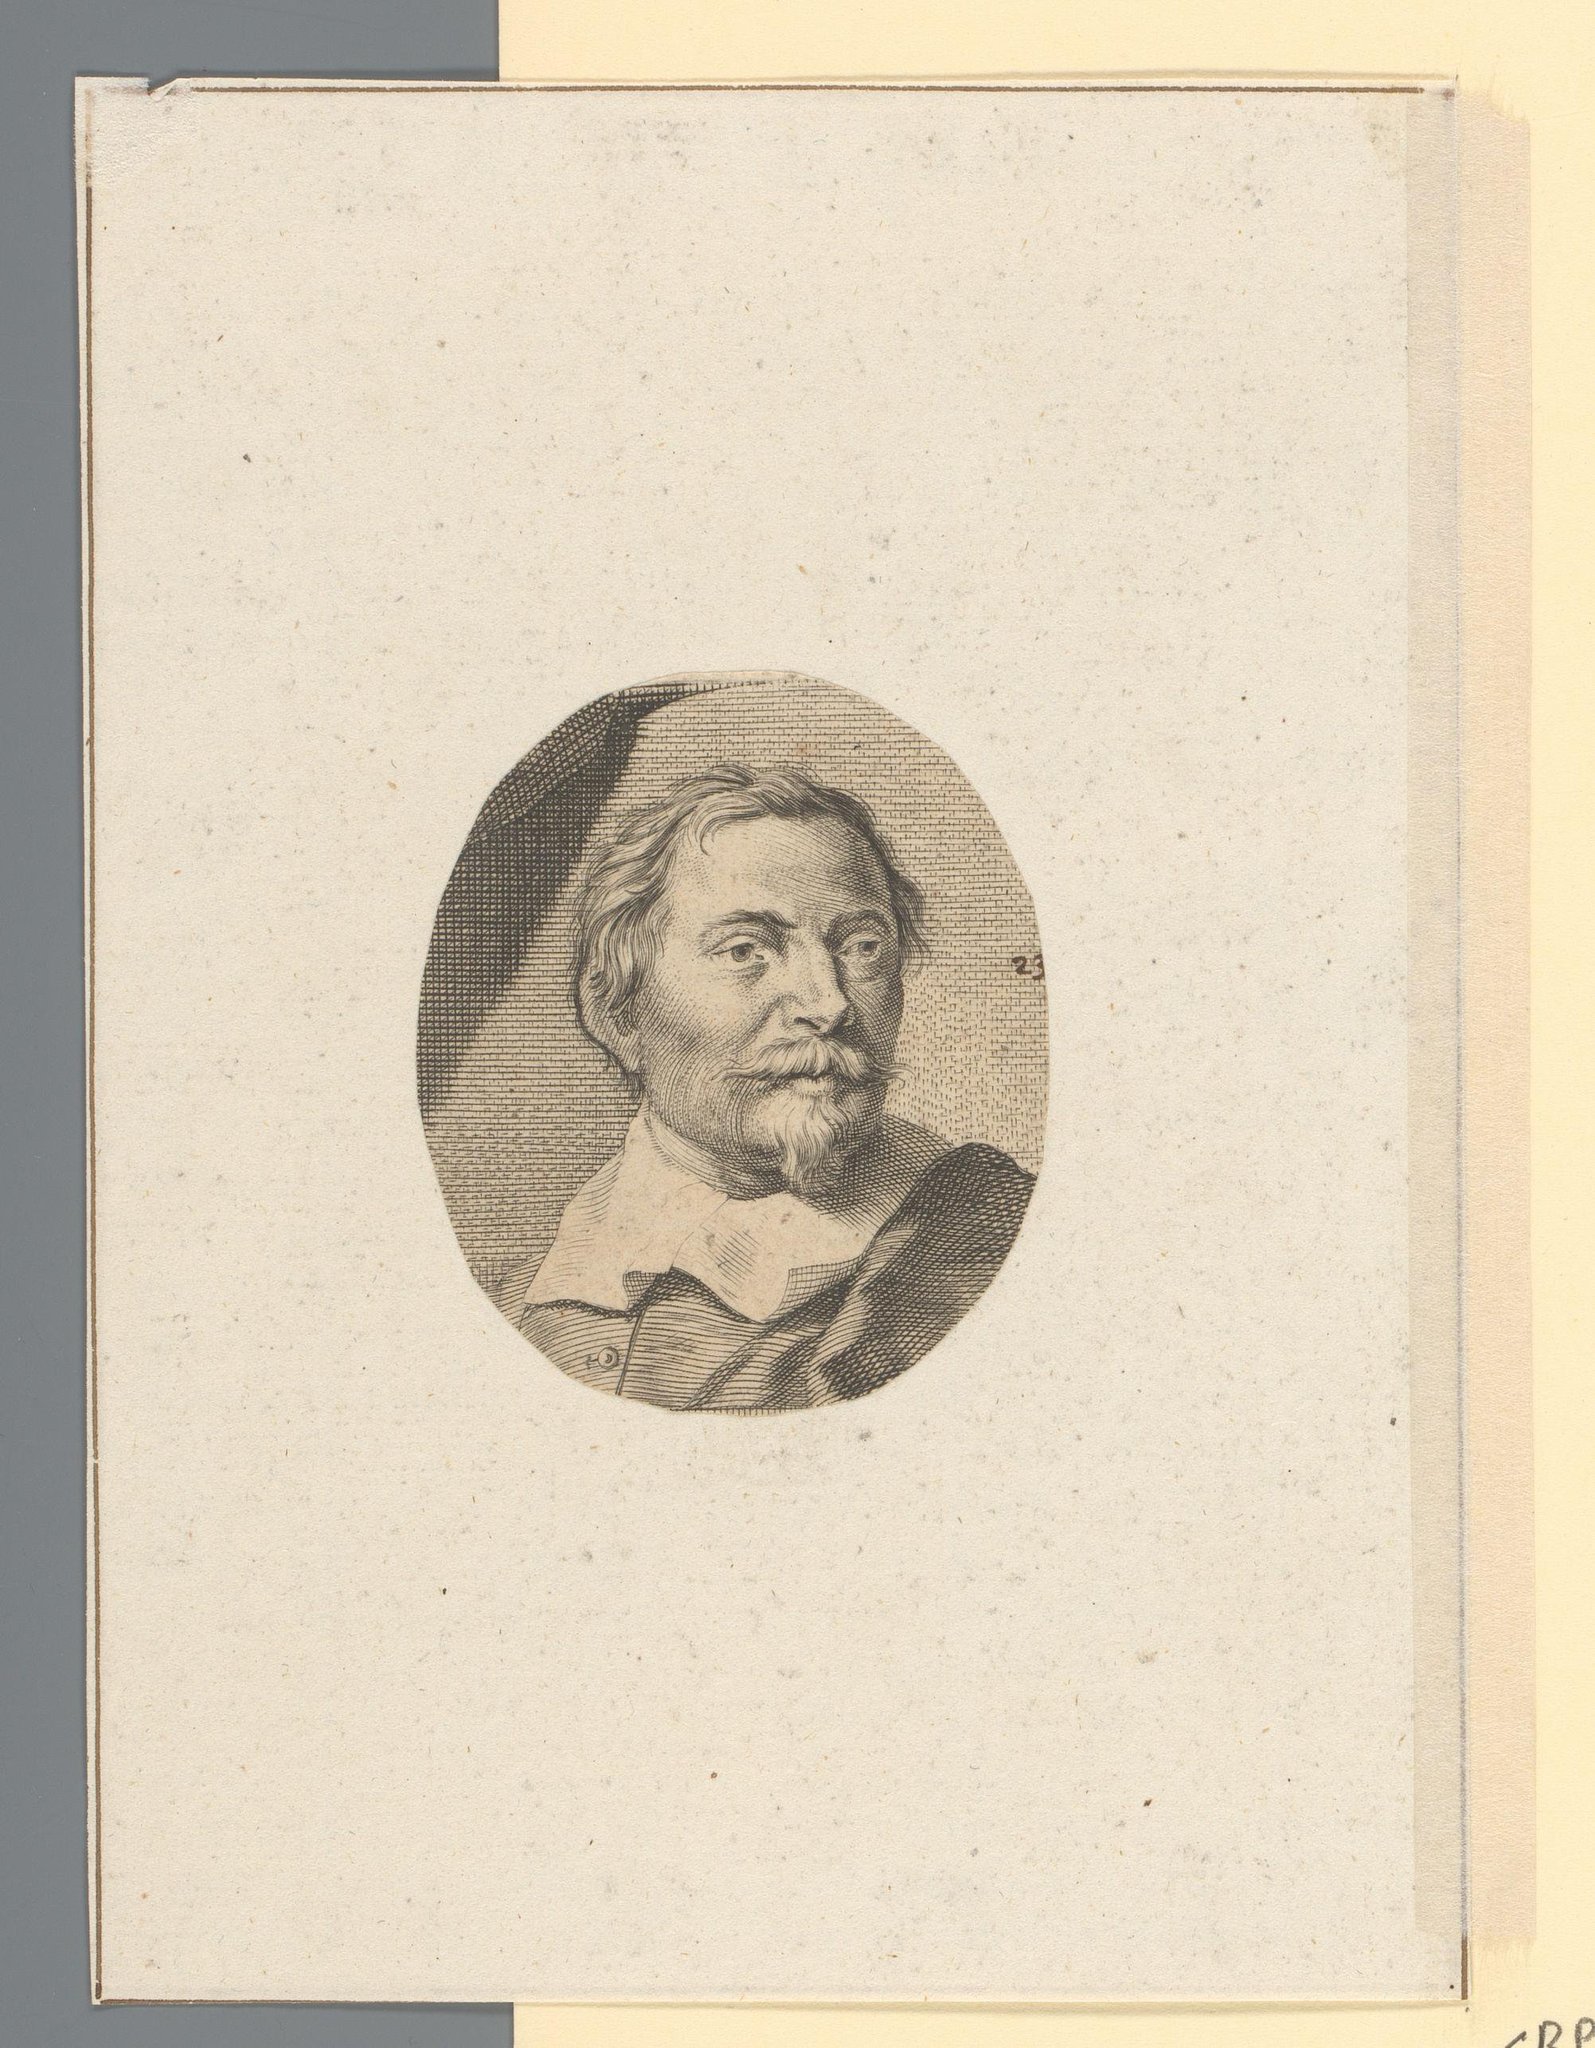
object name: print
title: Portret van Jacques Jordaens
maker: jacob houbraken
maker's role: draughtsman, print maker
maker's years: 1698-1780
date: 1729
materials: paper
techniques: engraving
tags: antwerp, painter, print maker, designer, jacques jordaens, historical persons, portrait, self-portrait of painter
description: Deze prent maakt deel uit van een grotere prent met twee portretten die later is verknipt. Prent mogelijk uit: Jacob Campo Weyerman. De levens-beschryvingen der Nederlandsche konst-schilders (...). Den Haag: weduwe Engelbrecht Boucquet, 1729, dl. 1, p. 382.